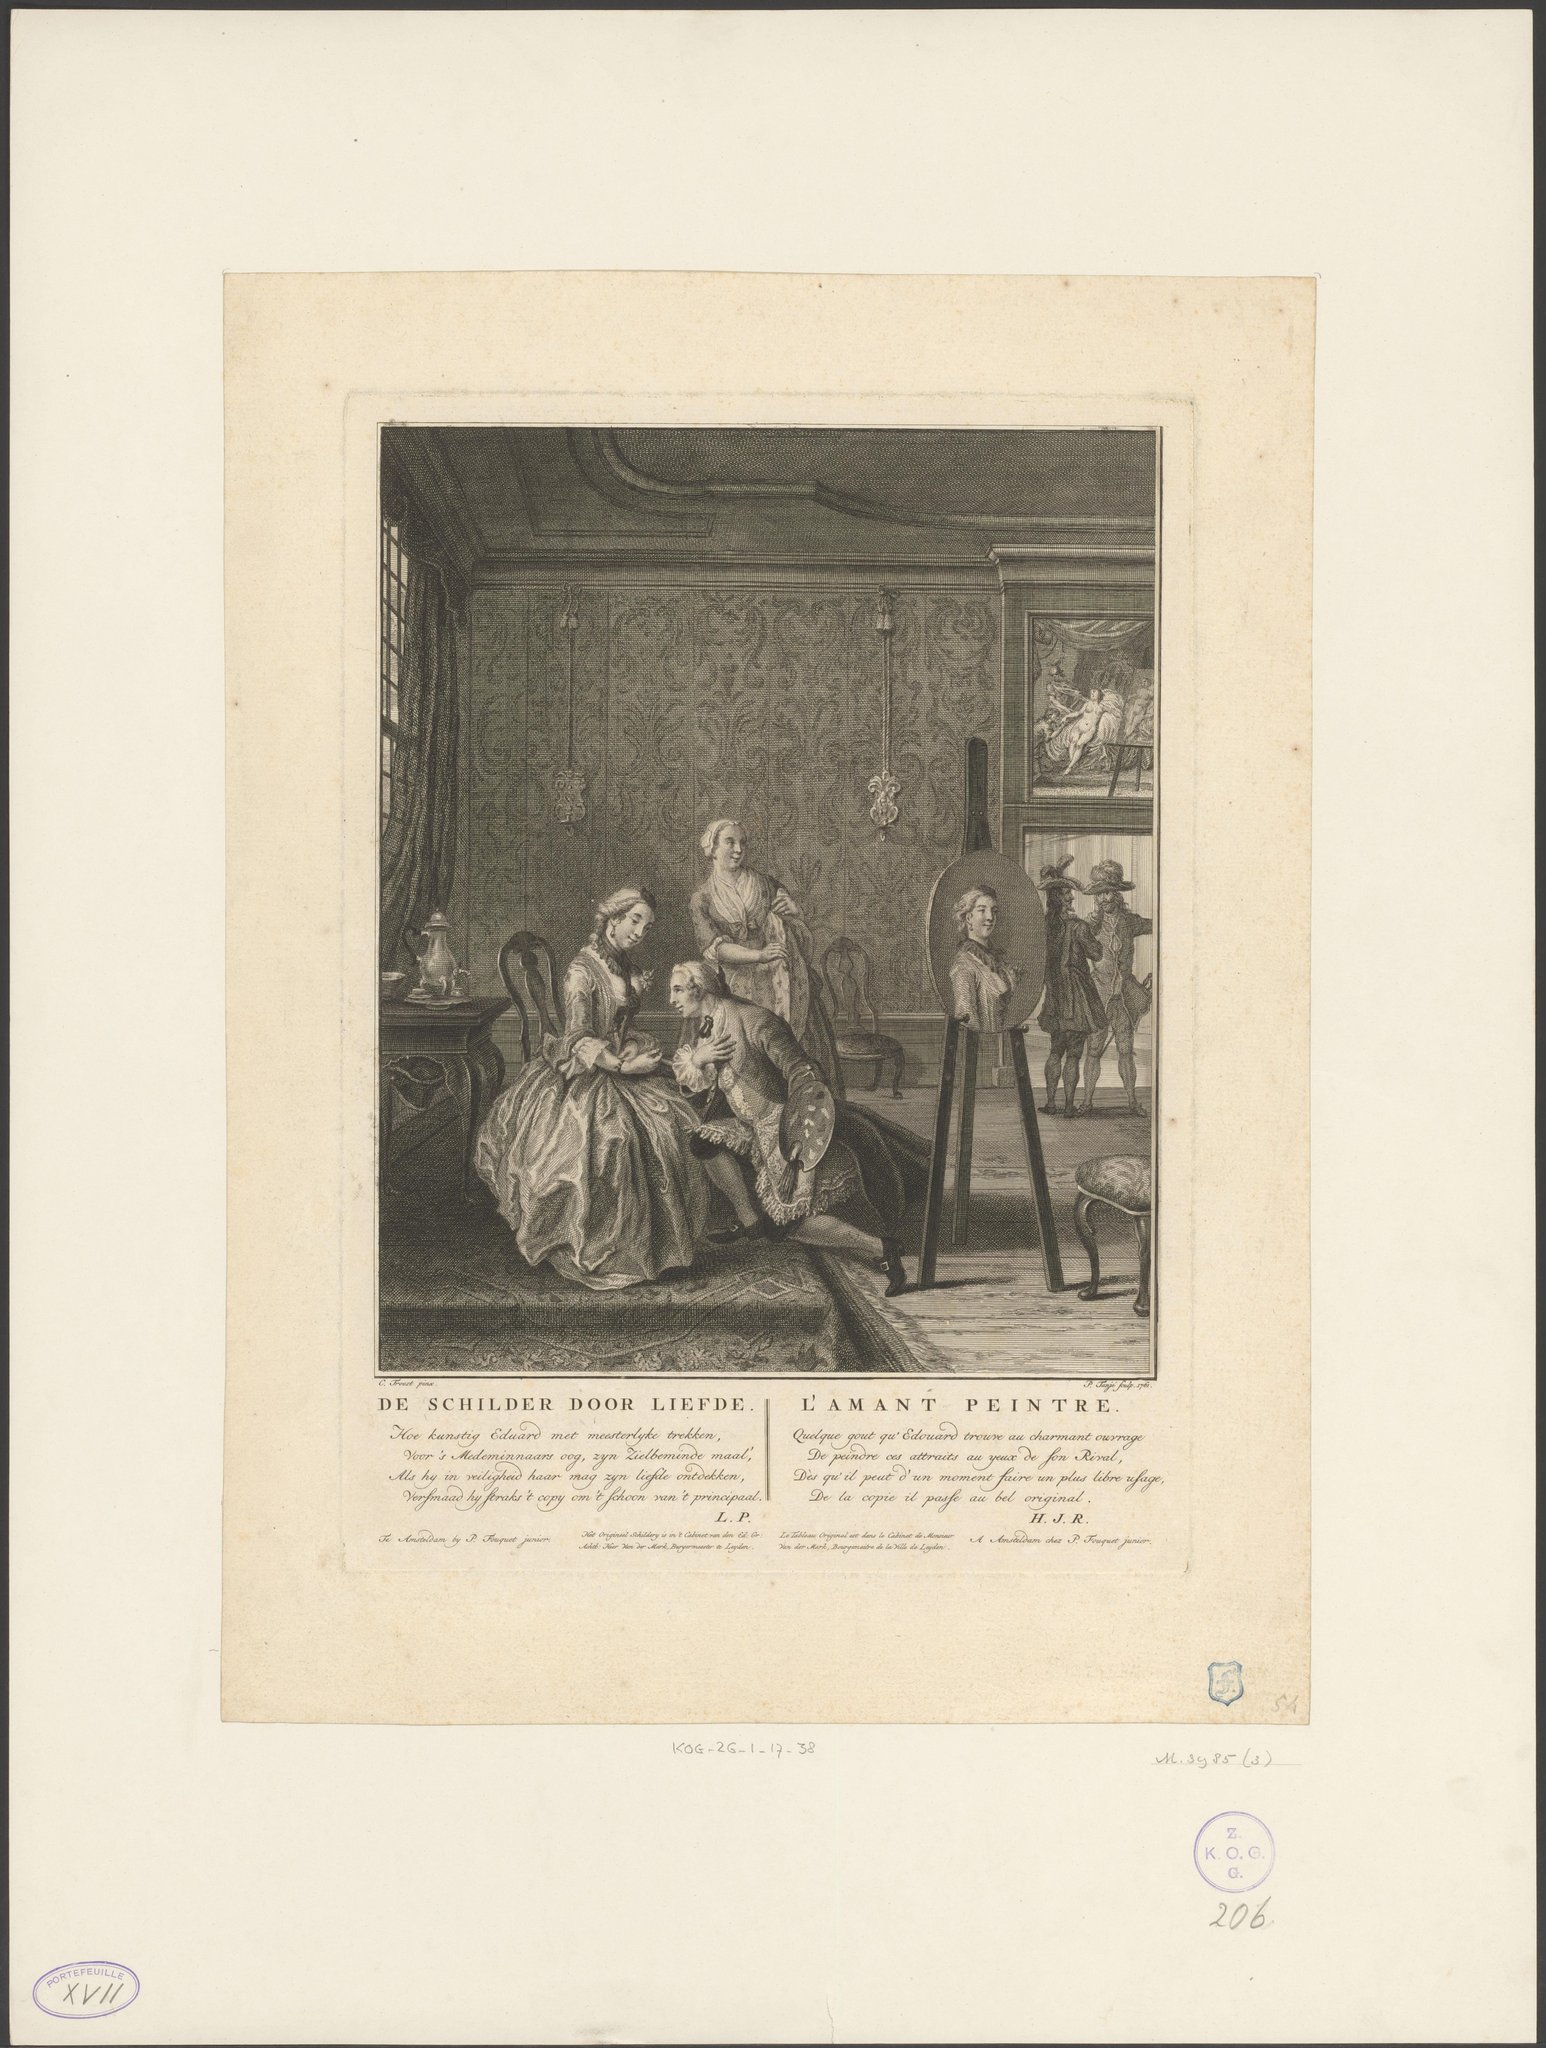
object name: print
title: Verliefde schilder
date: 1761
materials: paper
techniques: engraving, etching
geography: amsterdam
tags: kneeling figure, apelles paints campaspe and falls in love with her; alexander yields her to him, painter working from clothed model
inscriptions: stamp, collector's mark: Lugt 1641, collector's mark: Lugt 963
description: De schilder Eduard verklaart Leonoor, wiens portret hij vervaardigd heeft, zijn liefde. Bij de deur staat Leonoors jaloerse man Don Pedro, die door de schildersknecht bezig wordt gehouden. Boven de deur hangt een schilderij met een voorstelling van Alexander, die de schilder Apelles zijn minnares Campaspe ten geschenke geeft. Onderaan in de marge een vierregelig vers in het Nederlands en het Frans. Scène uit het tweede bedrijf van het toneelstuk De schilder door liefde, van Molière. Onderwerpsrubrieken binnen de Atlas Zeden en Gewoonten: Tooneel, Prenten van Cornelis Troost.